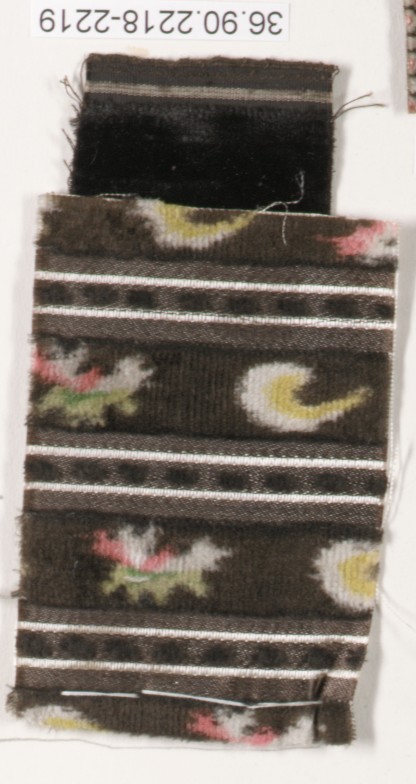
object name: piece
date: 1801-1900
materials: silk